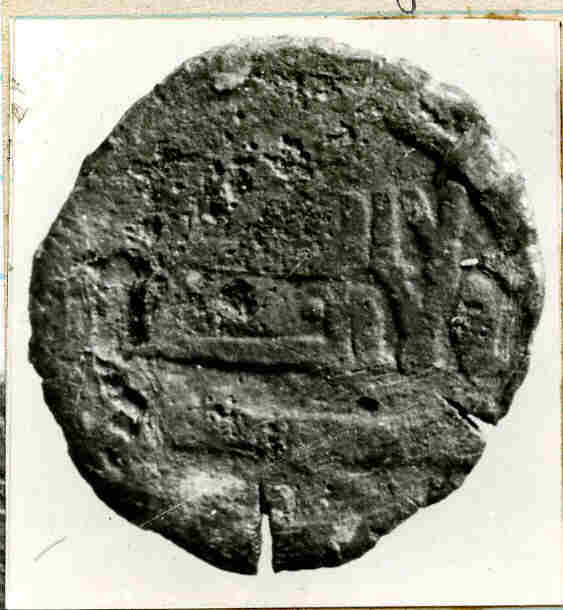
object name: coin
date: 701-900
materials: copper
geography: iran